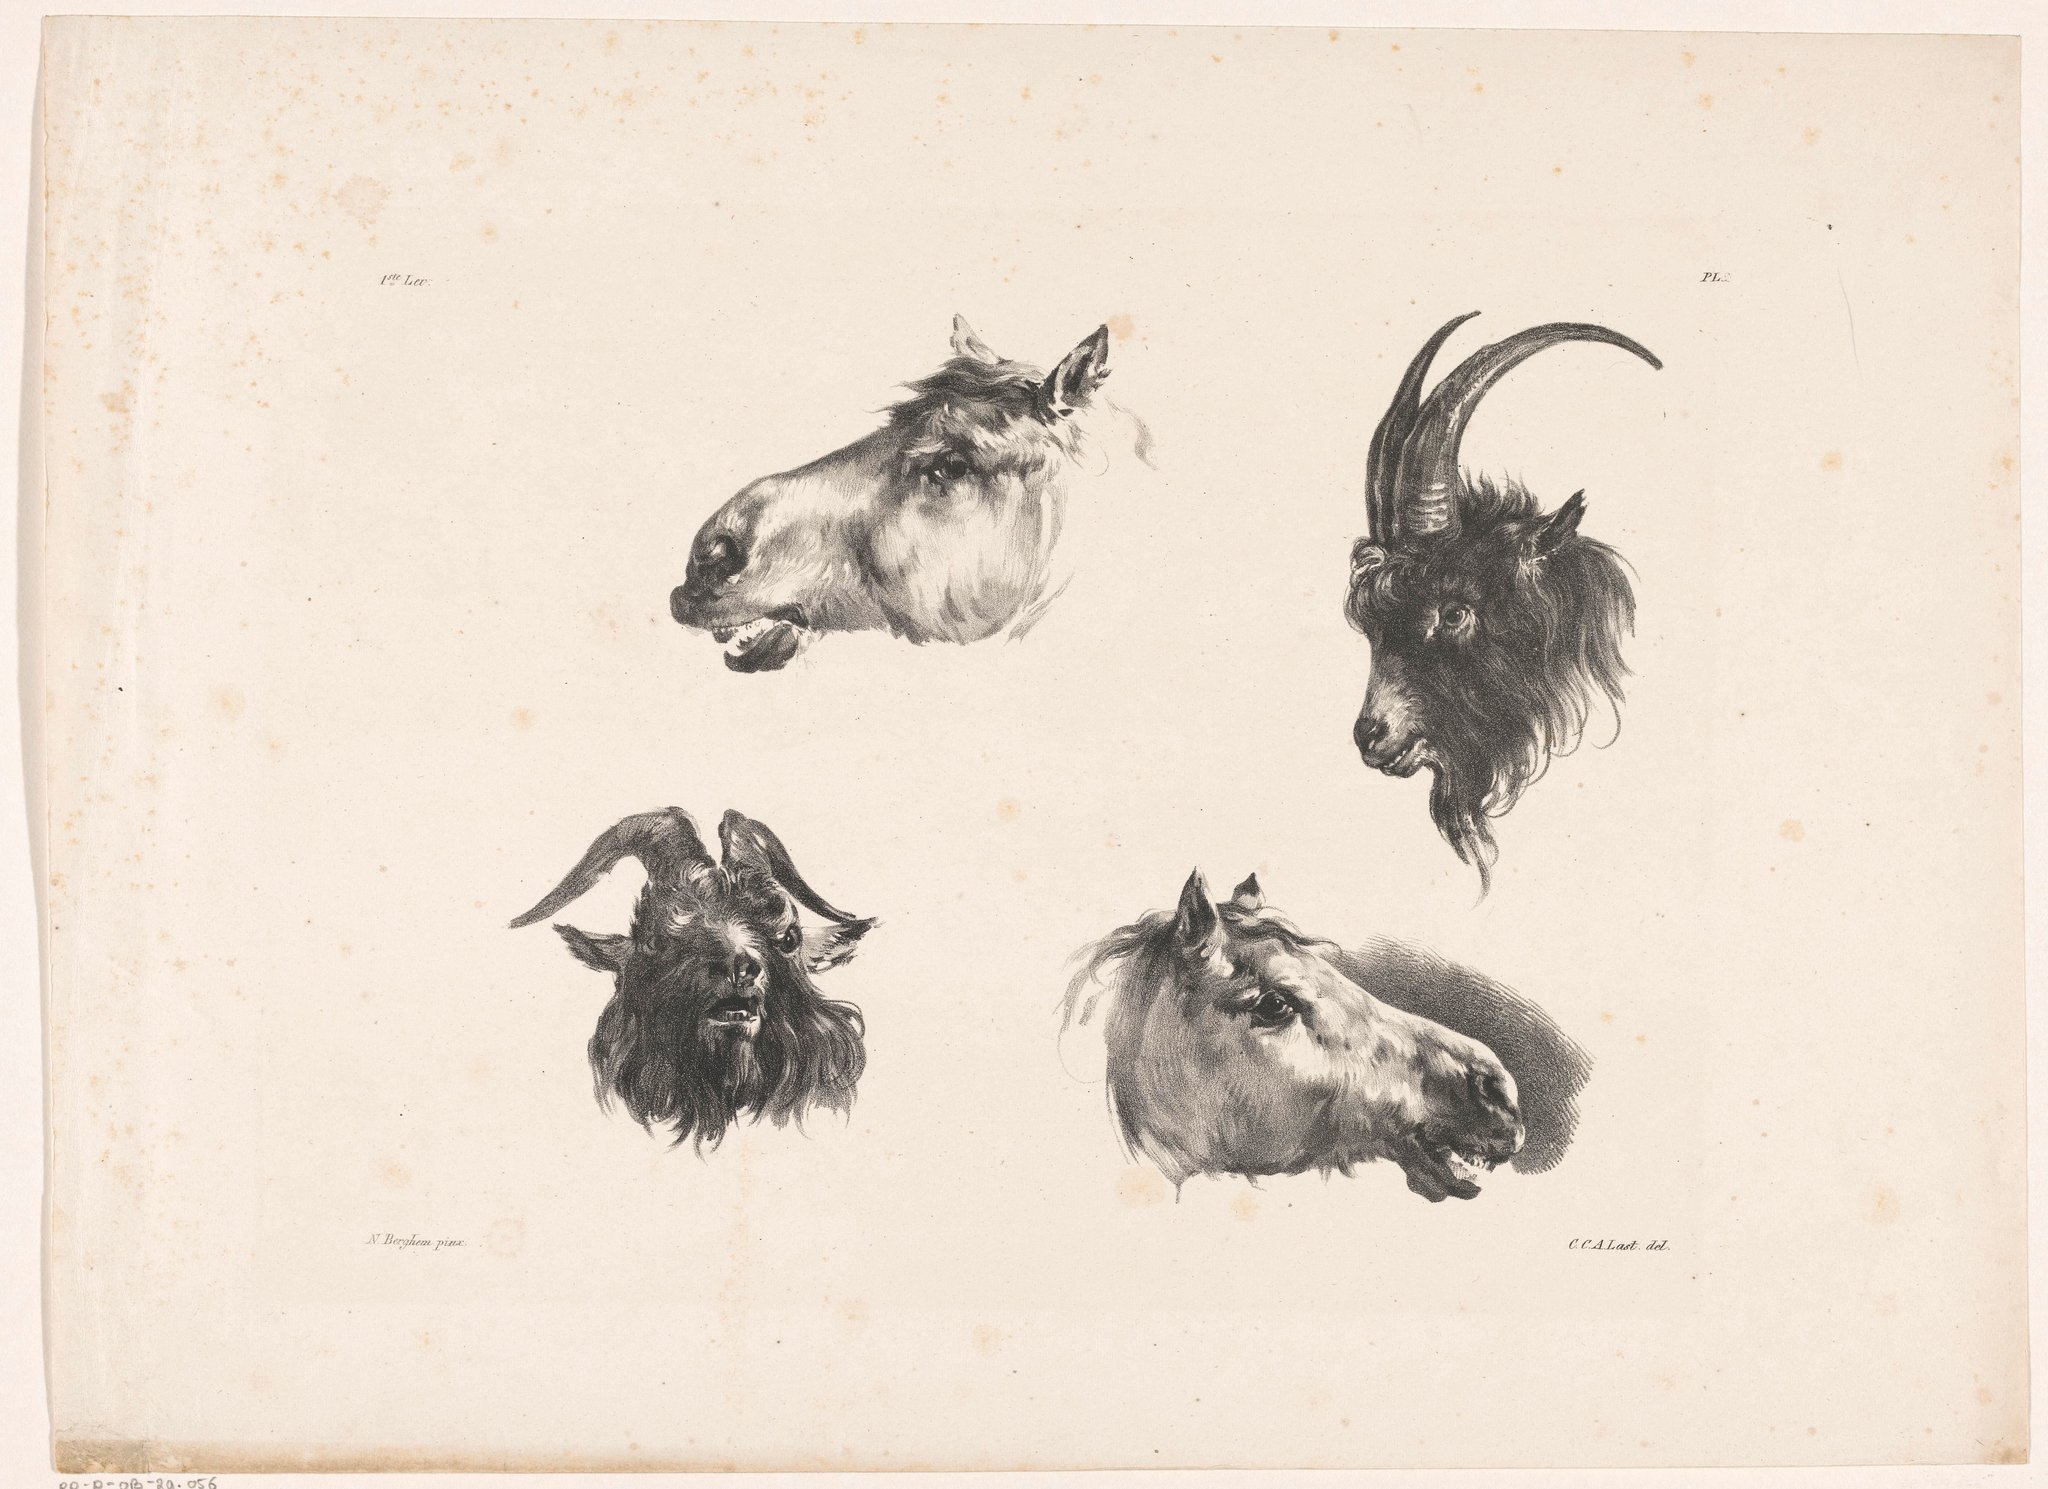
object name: print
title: Twee paardenhoofden en twee ramskoppen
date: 1818-1876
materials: paper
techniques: lithograph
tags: he-goat, billy-goat, horse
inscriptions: collector's mark: Lugt 2228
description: Genummerd links- en rechtsboven: '1ste Lev' en 'Pl.2'